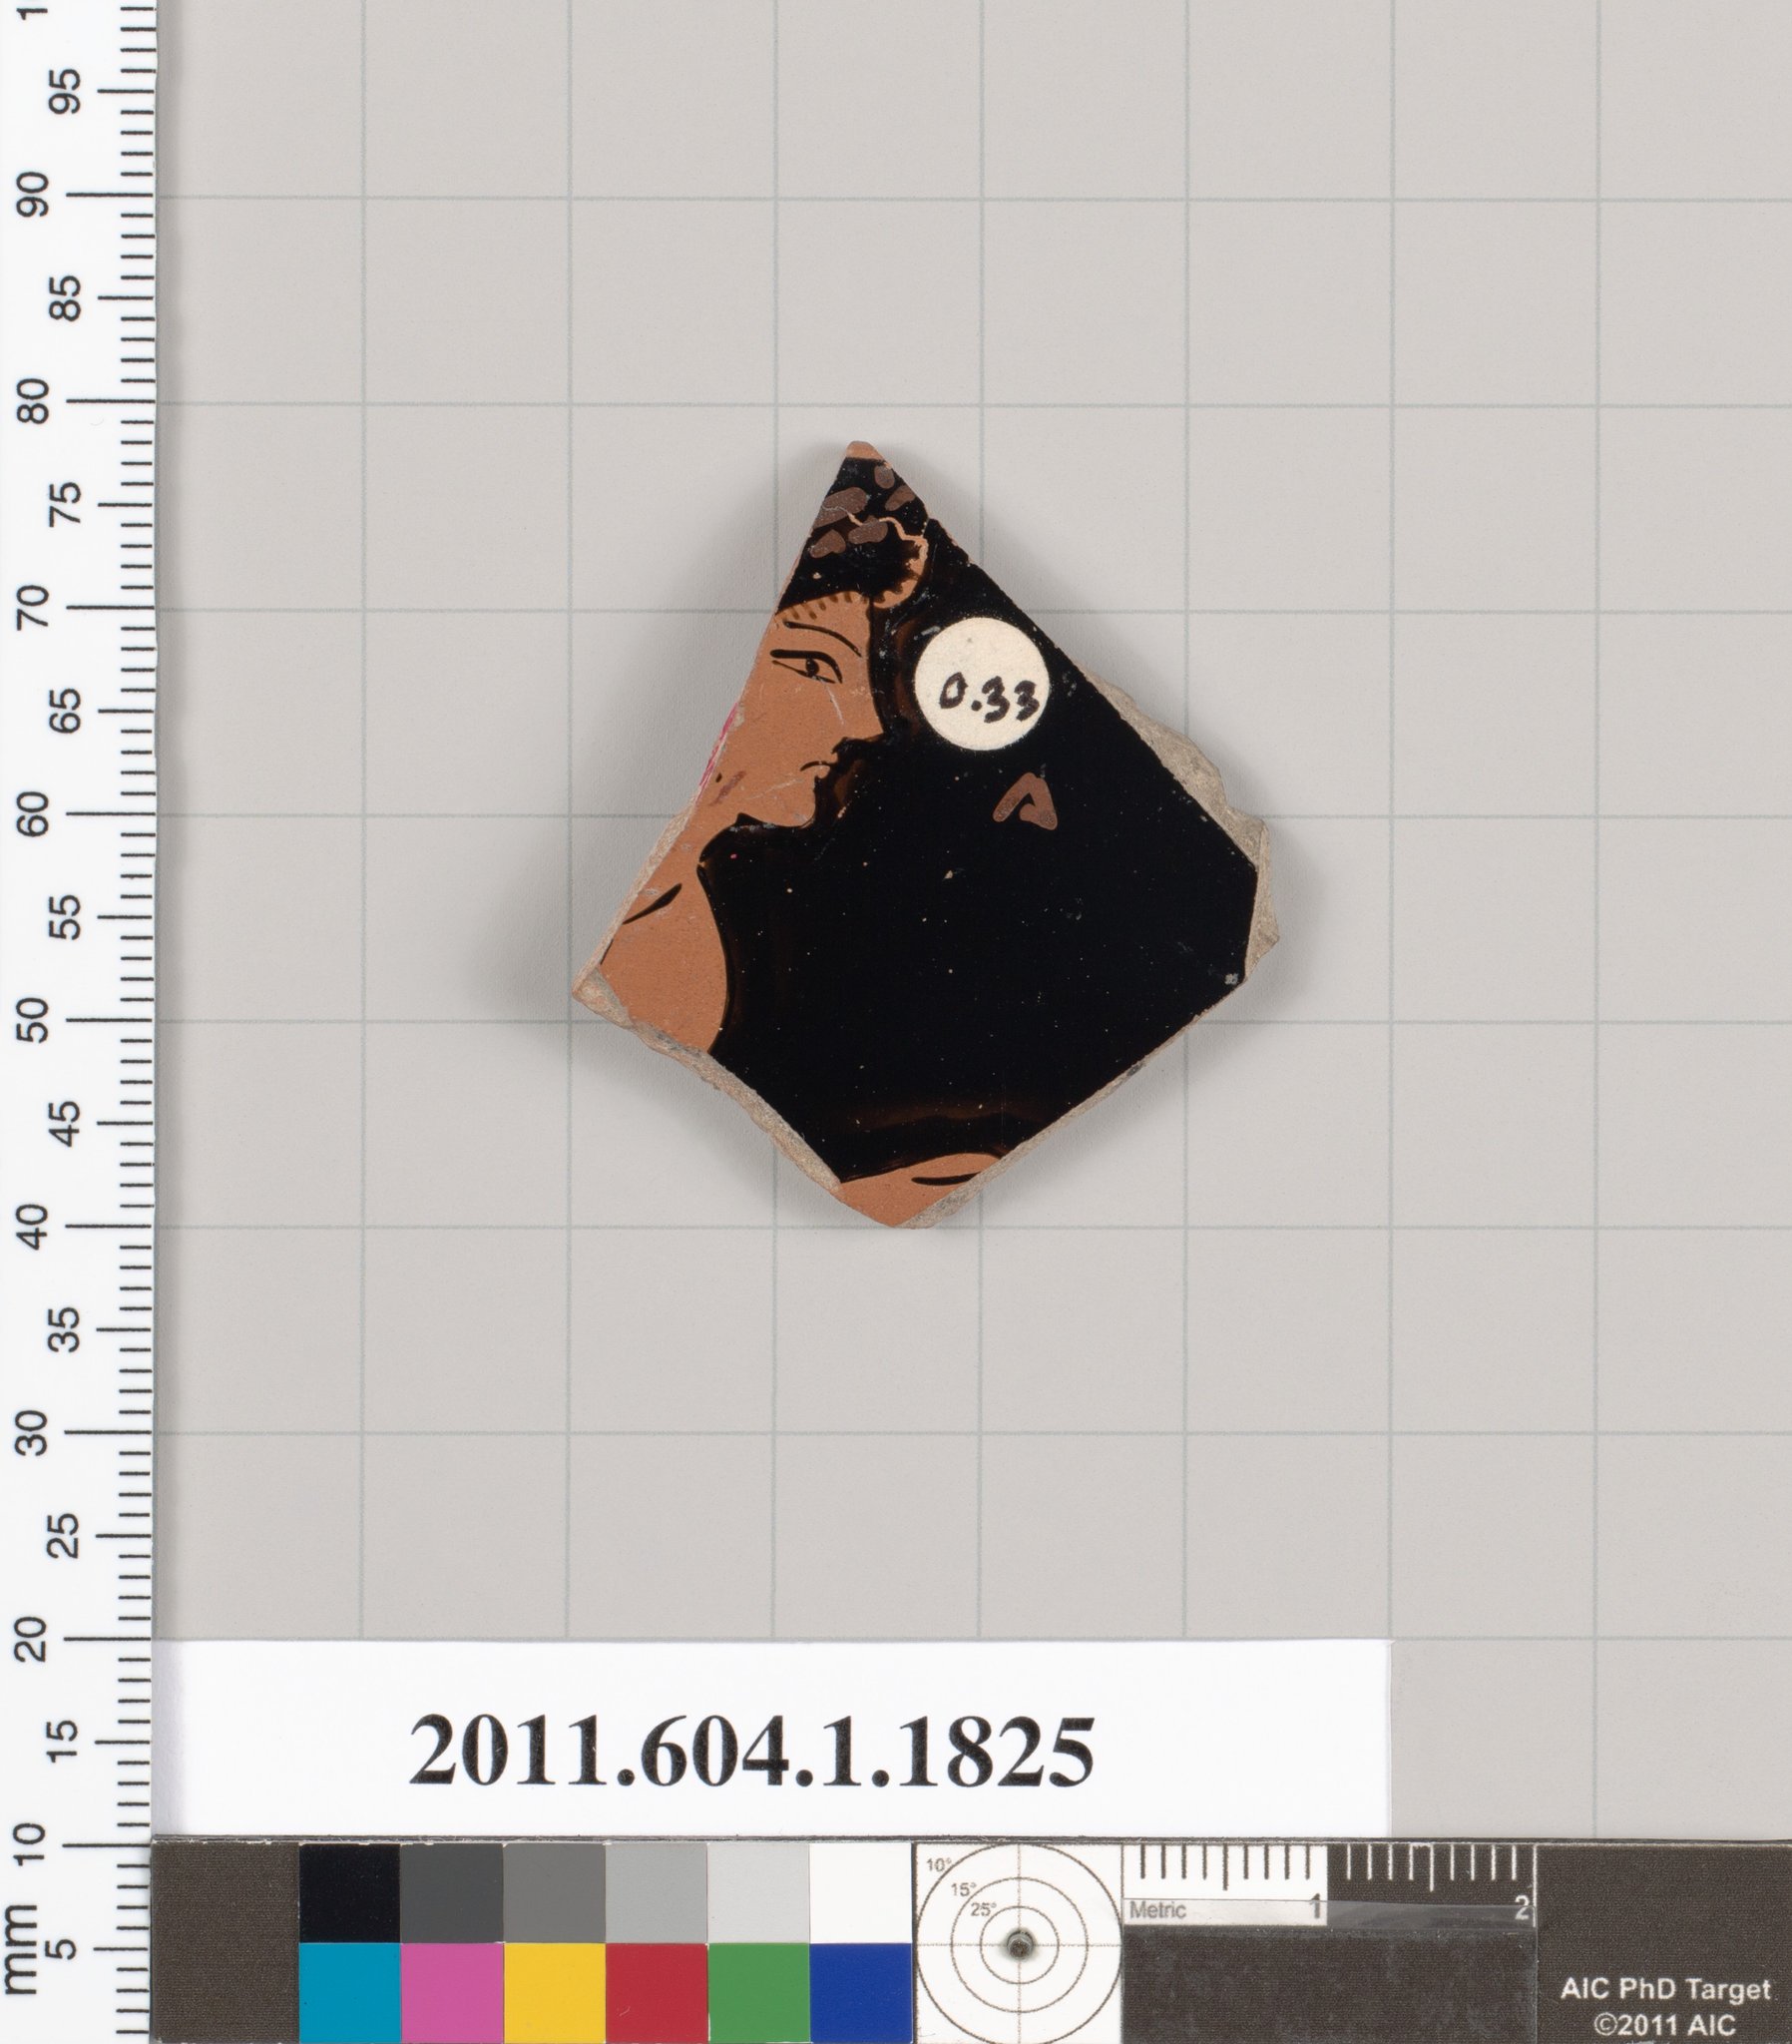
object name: kylix fragment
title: Terracotta rim fragment of a kylix (drinking cup)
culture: greek, attic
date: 510-500 BCE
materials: terracotta